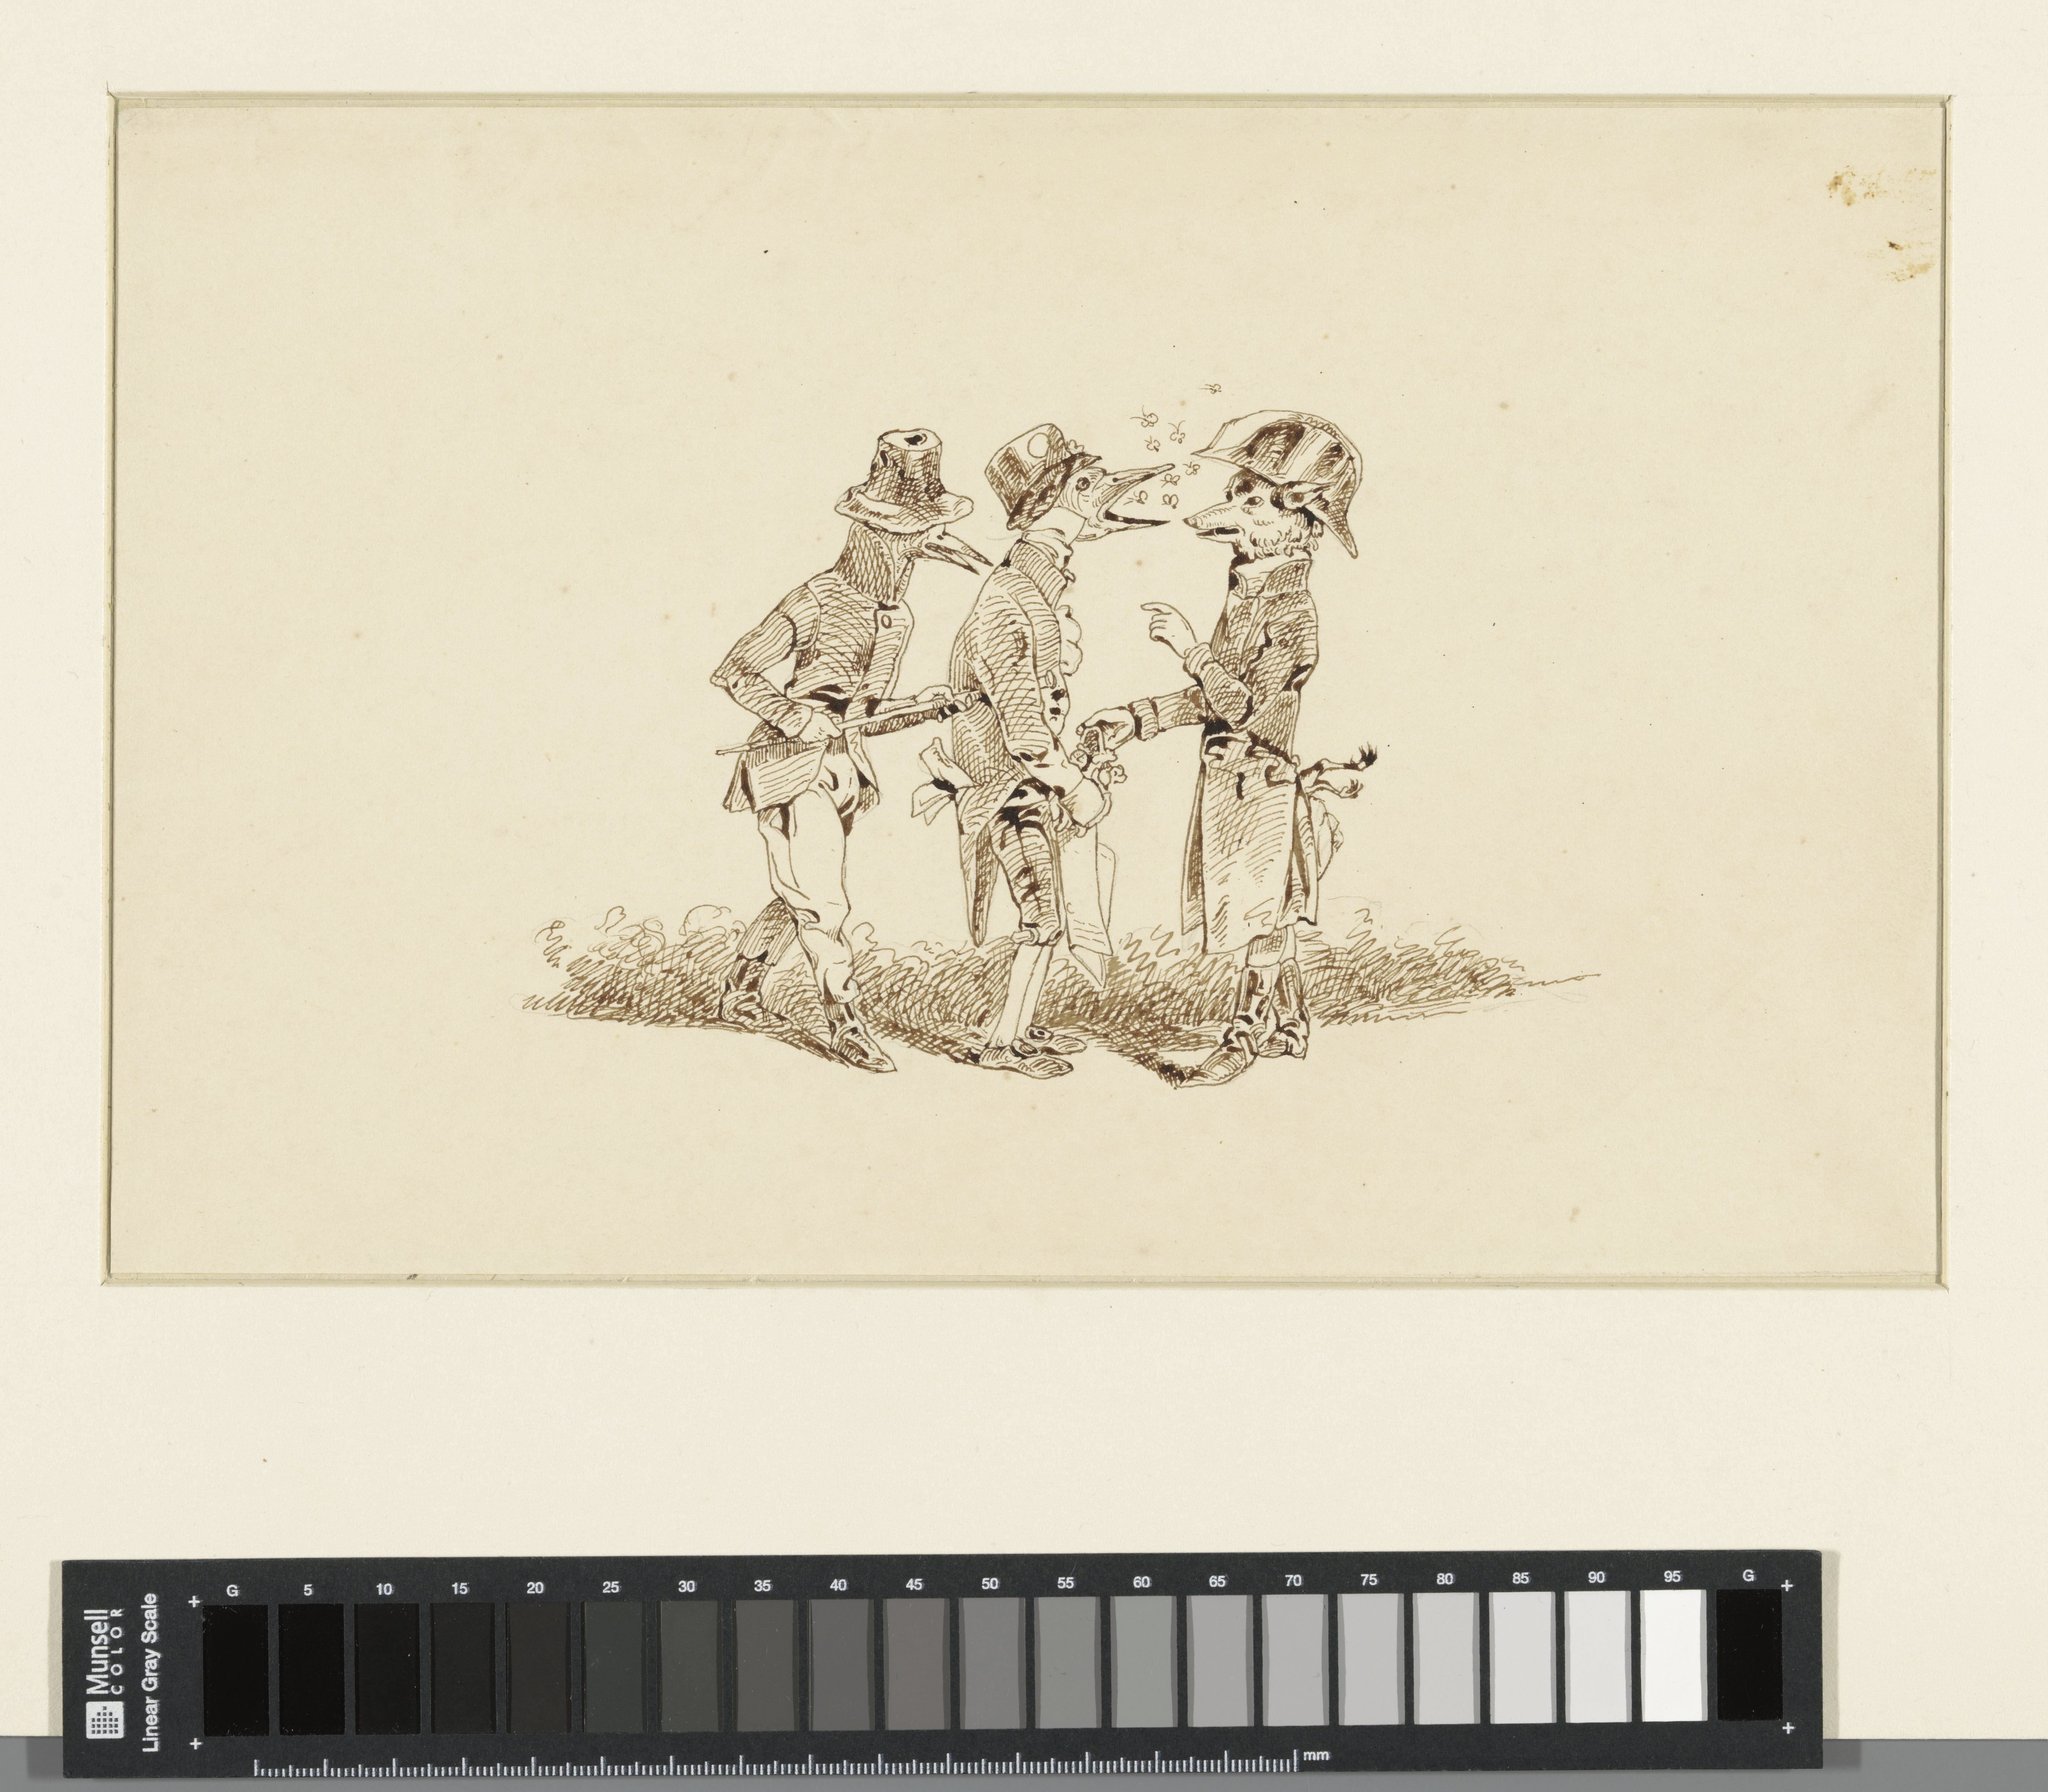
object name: drawing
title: Zeven pentekeningen van dierfabels van Wilhelm Koller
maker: wilhelm koller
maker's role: draughtsman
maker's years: 1829-1884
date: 1839-1884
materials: ink, paper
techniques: pen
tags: animals acting as human beings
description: Een vos, komend van rechts, een kippetje opzij dragend, in gesprek met twee spreeuwen.